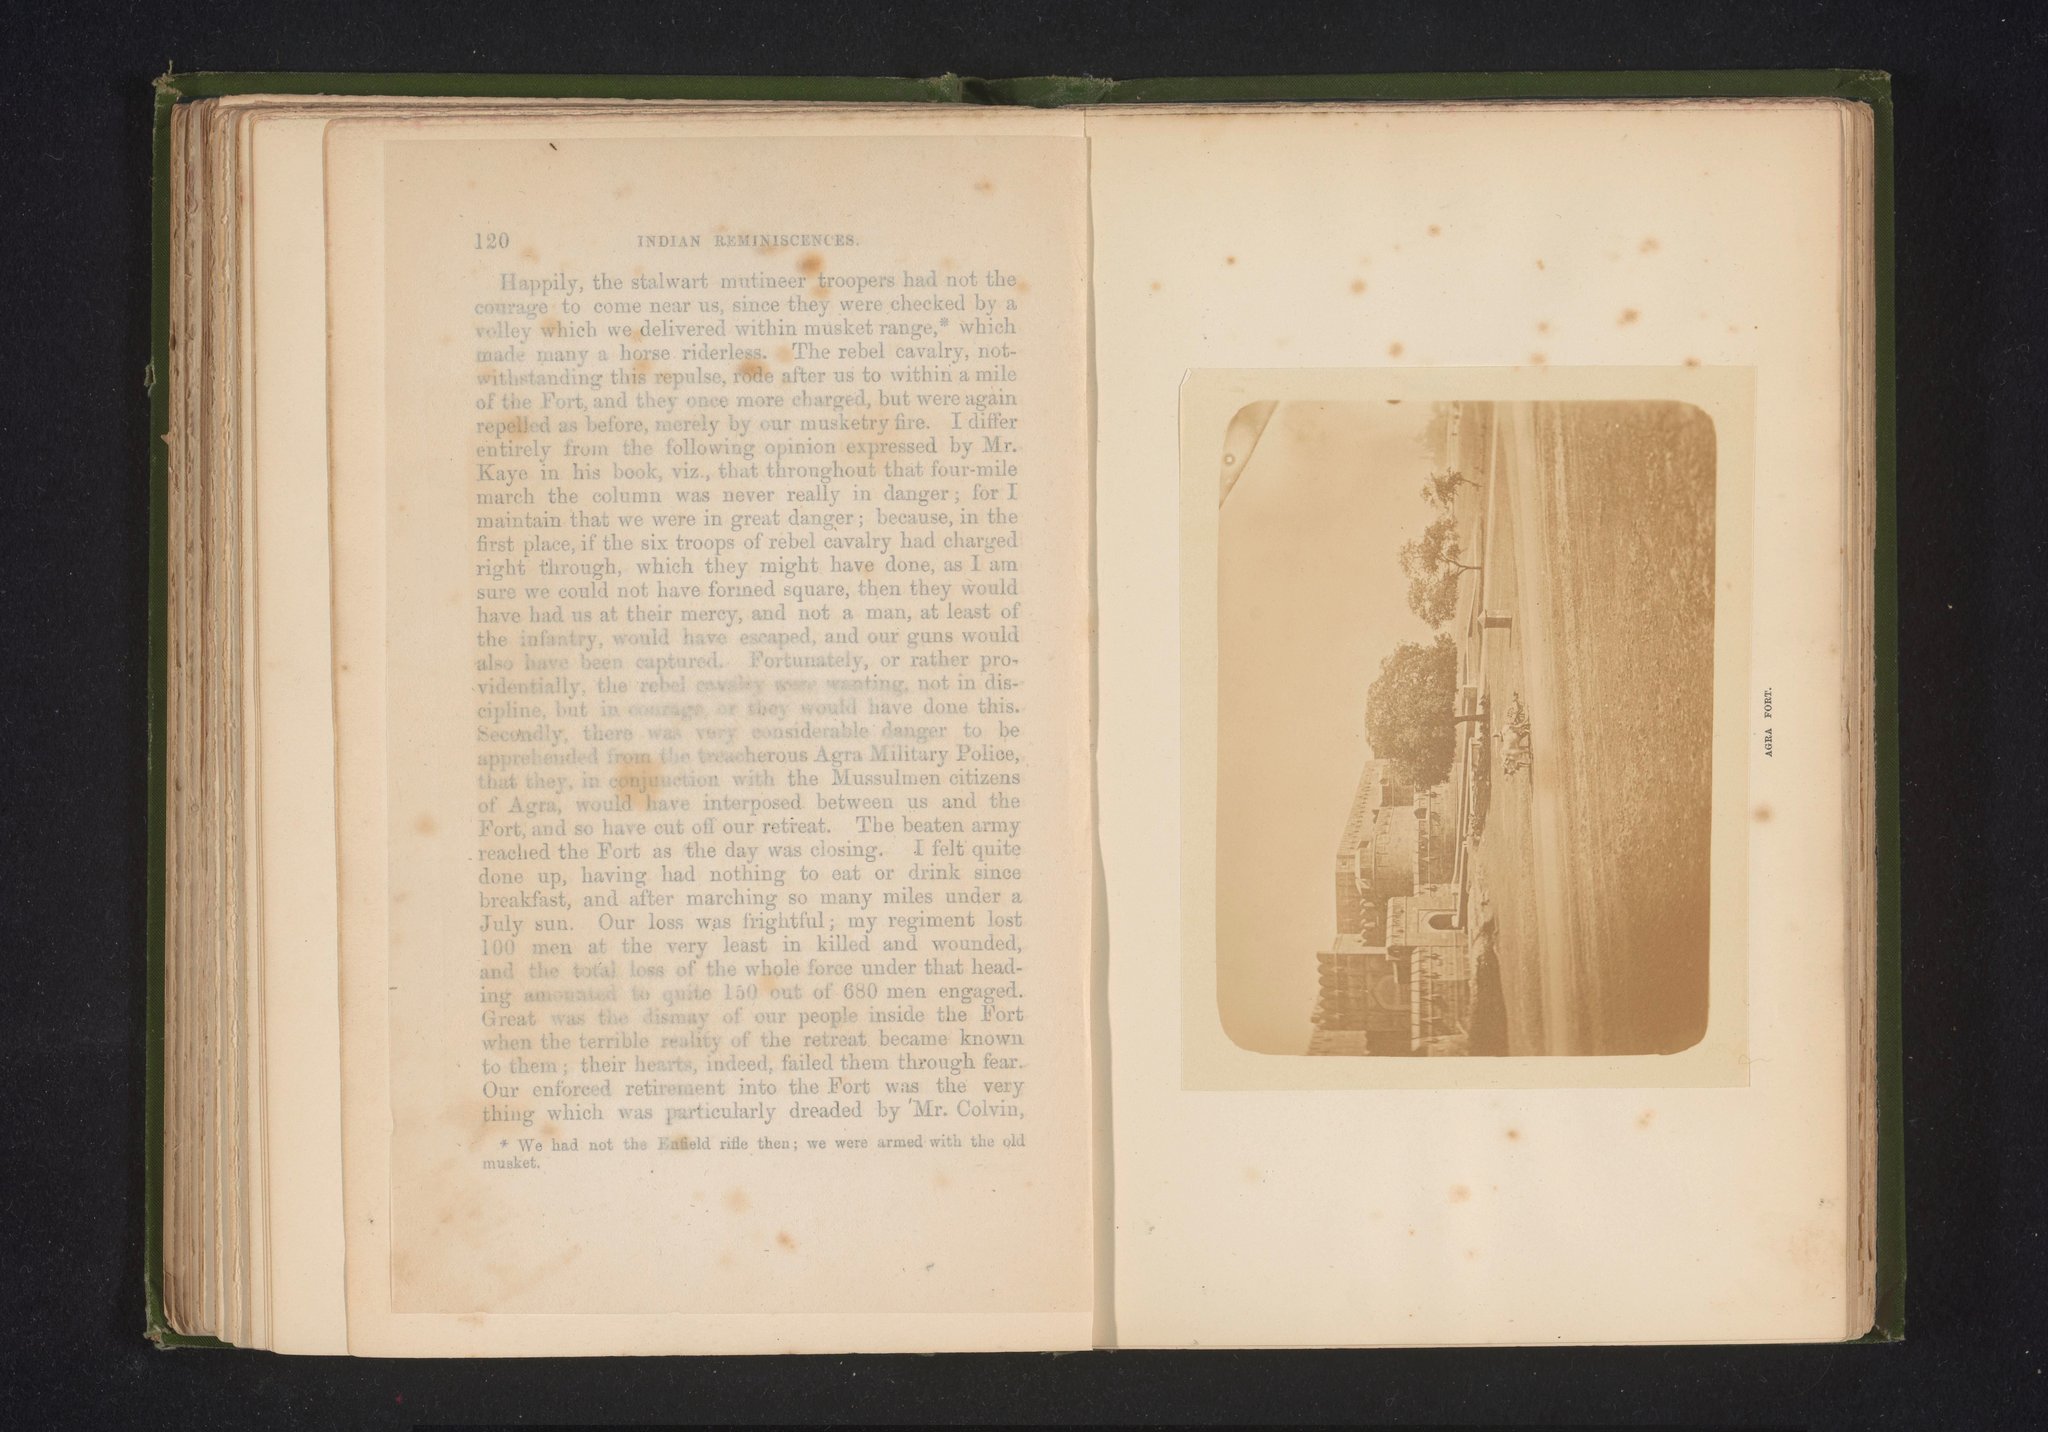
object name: page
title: Agra fort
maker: Anonymous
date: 1870-1880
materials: photographic support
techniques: albumen print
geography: agra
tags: fortress, façade (of house or building)